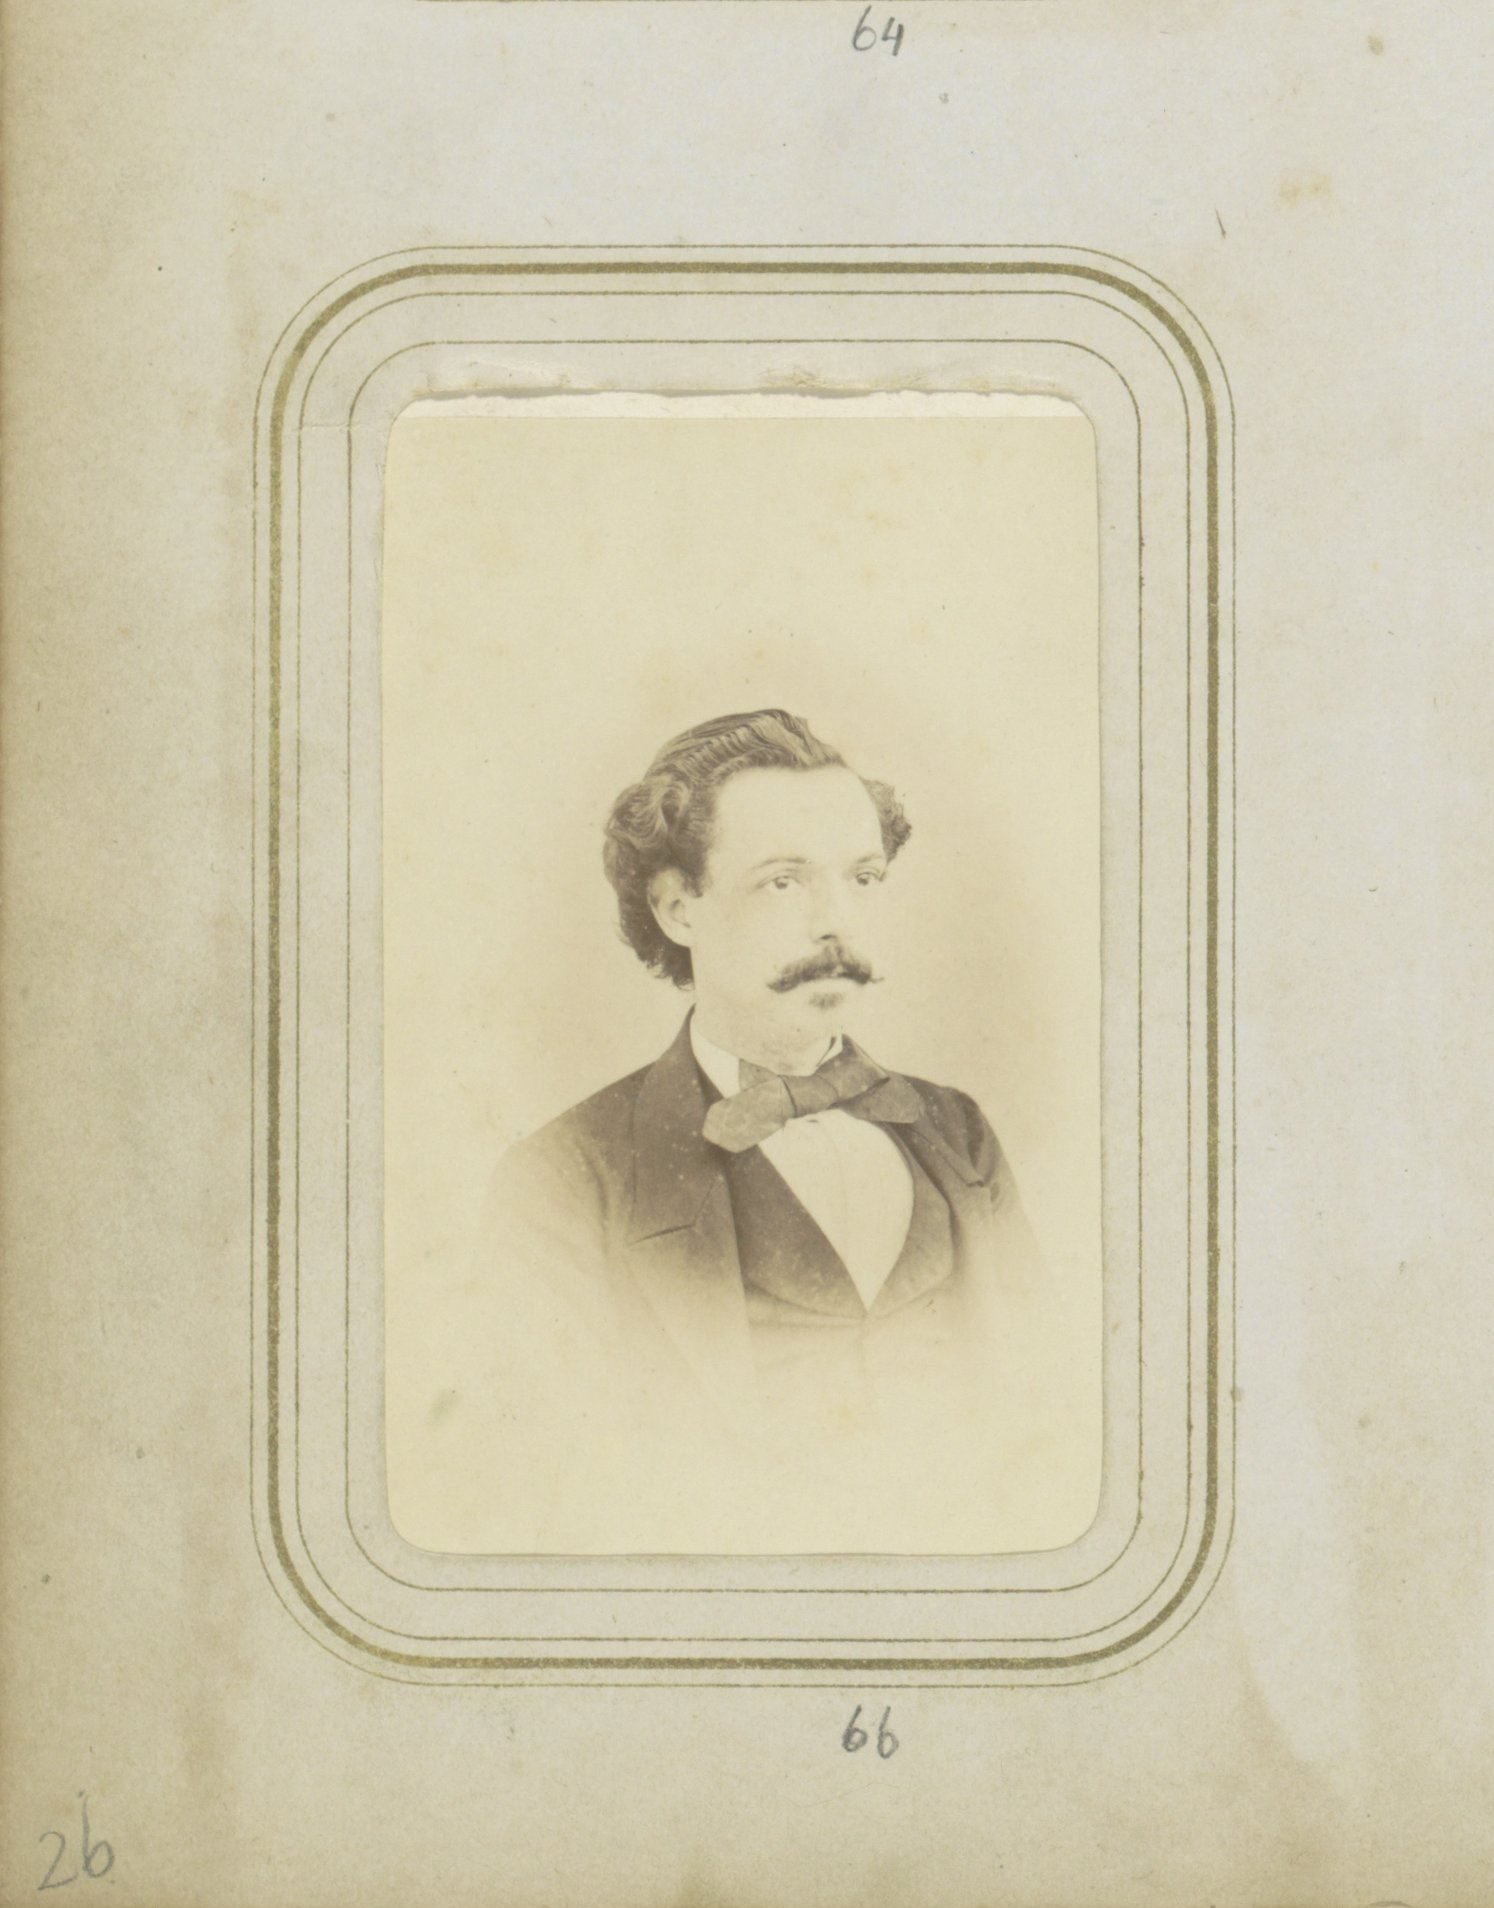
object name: carte de visite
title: Portret van een man met een snor en een strikje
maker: k. buwalda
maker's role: fotograaf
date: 1863-1870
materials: cardboard, photographic support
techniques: albumen print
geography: surabaya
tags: moustache, historical persons, neck-gear ~ clothing, clothing for the upper part of the body, family, relationship, descent, hairdress, surabaya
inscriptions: check stamp: ‘K. Buwalda. Soerebaya.’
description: Onderdeel van Familiealbum van H.W.F. Ligtenberg en L.M. Swart met 149 foto's en cartes-de-visite.